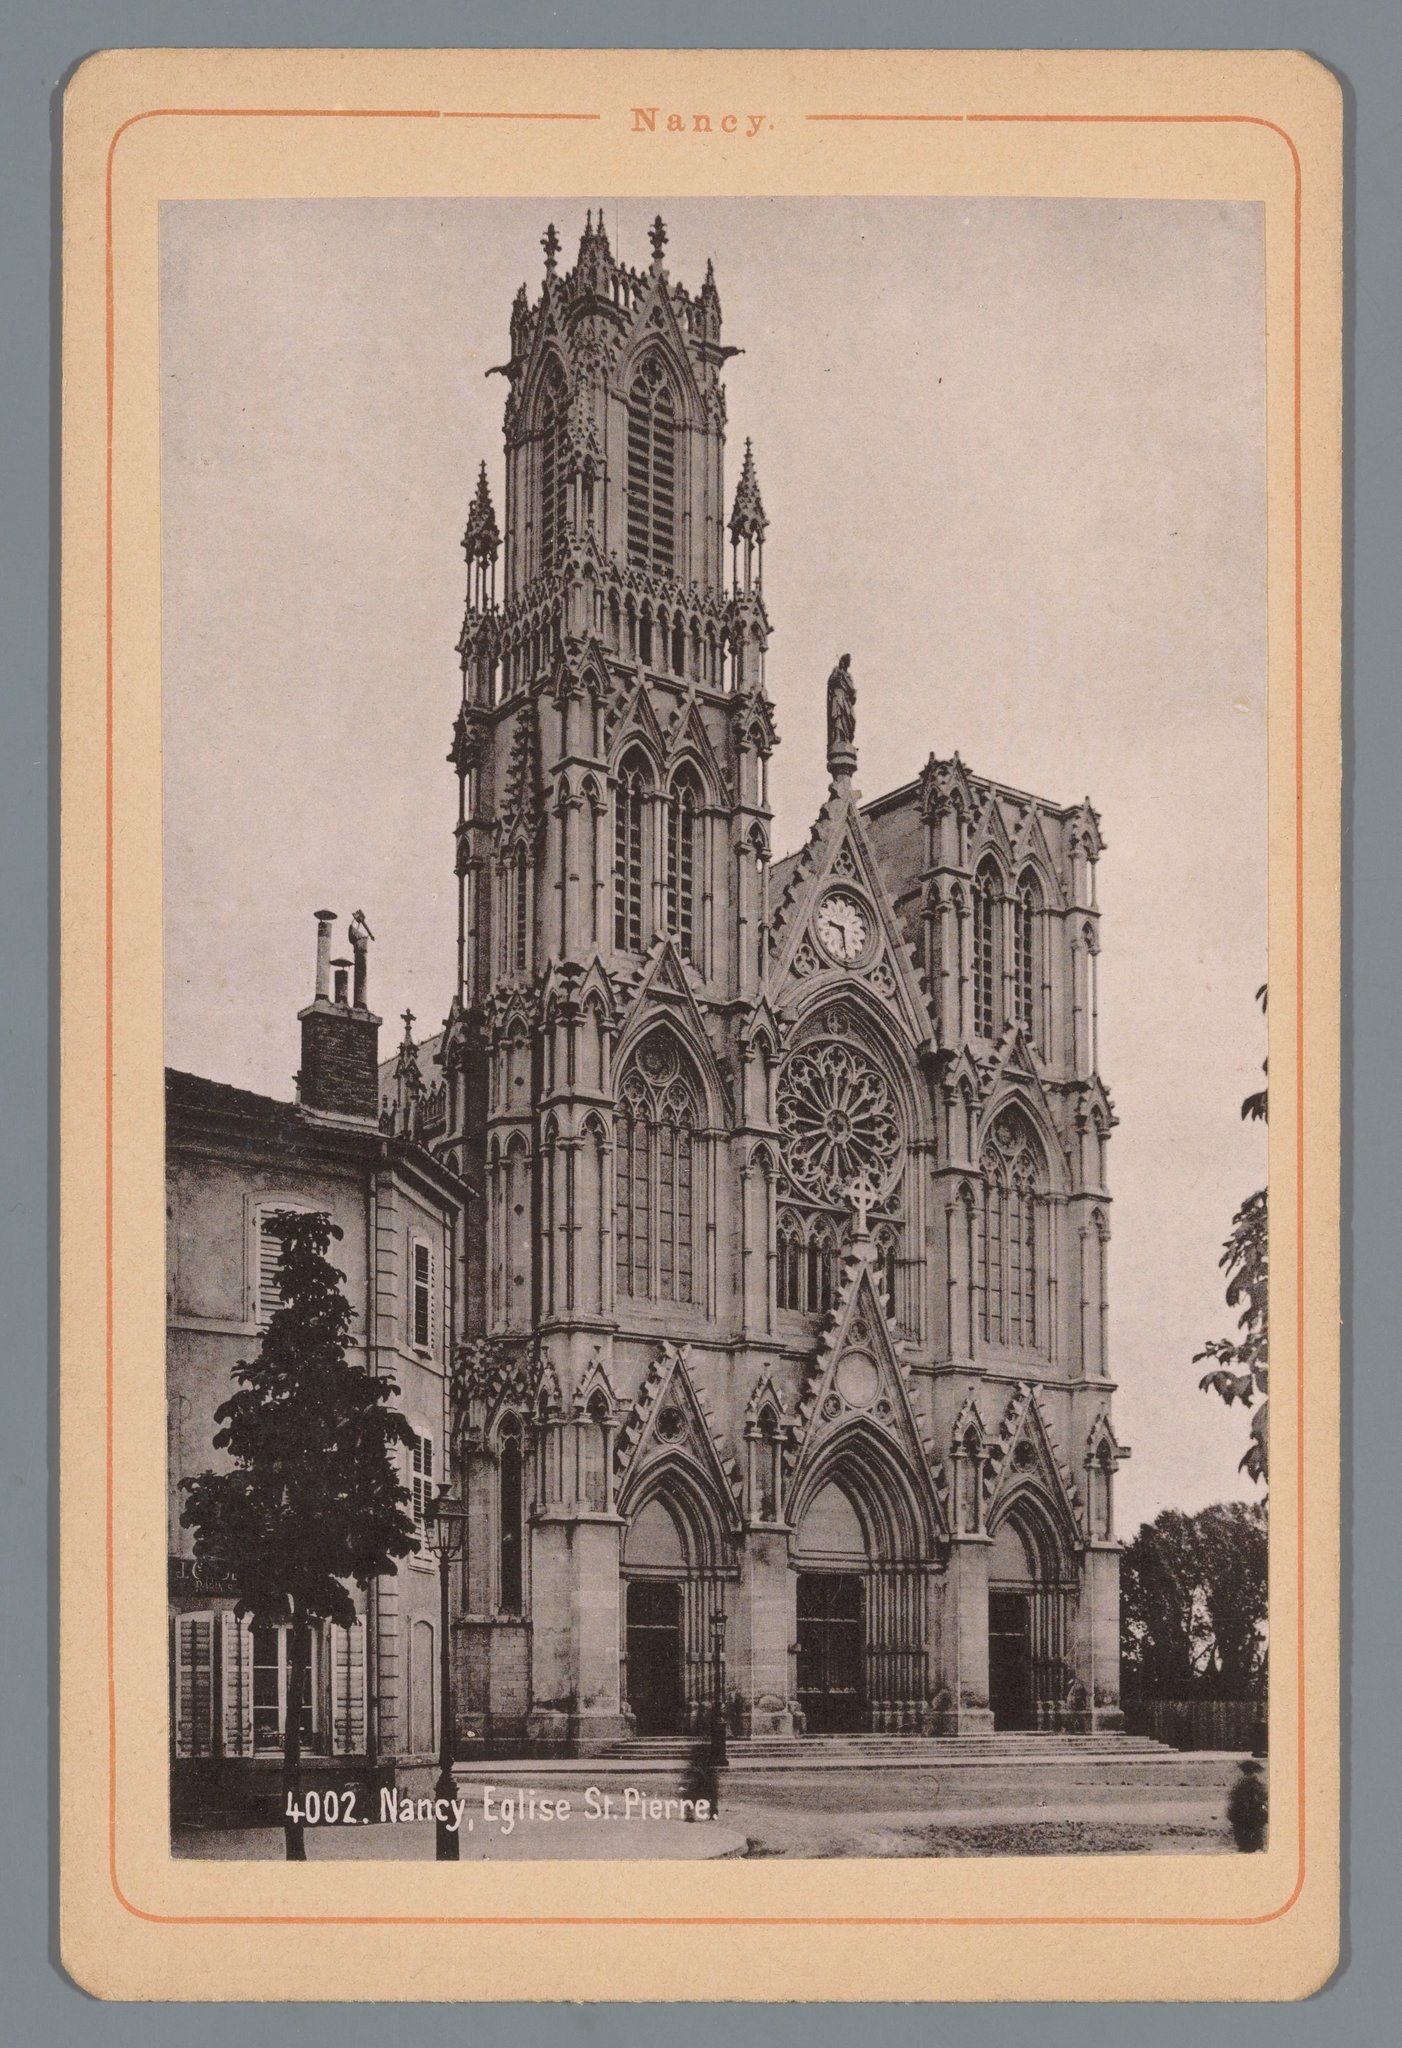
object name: cabinet photograph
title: Nancy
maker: Anonymous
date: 1875-1930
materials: cardboard, paper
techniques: photograph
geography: nancy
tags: church (exterior), façade (of house or building)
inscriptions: number: ‘4002.’